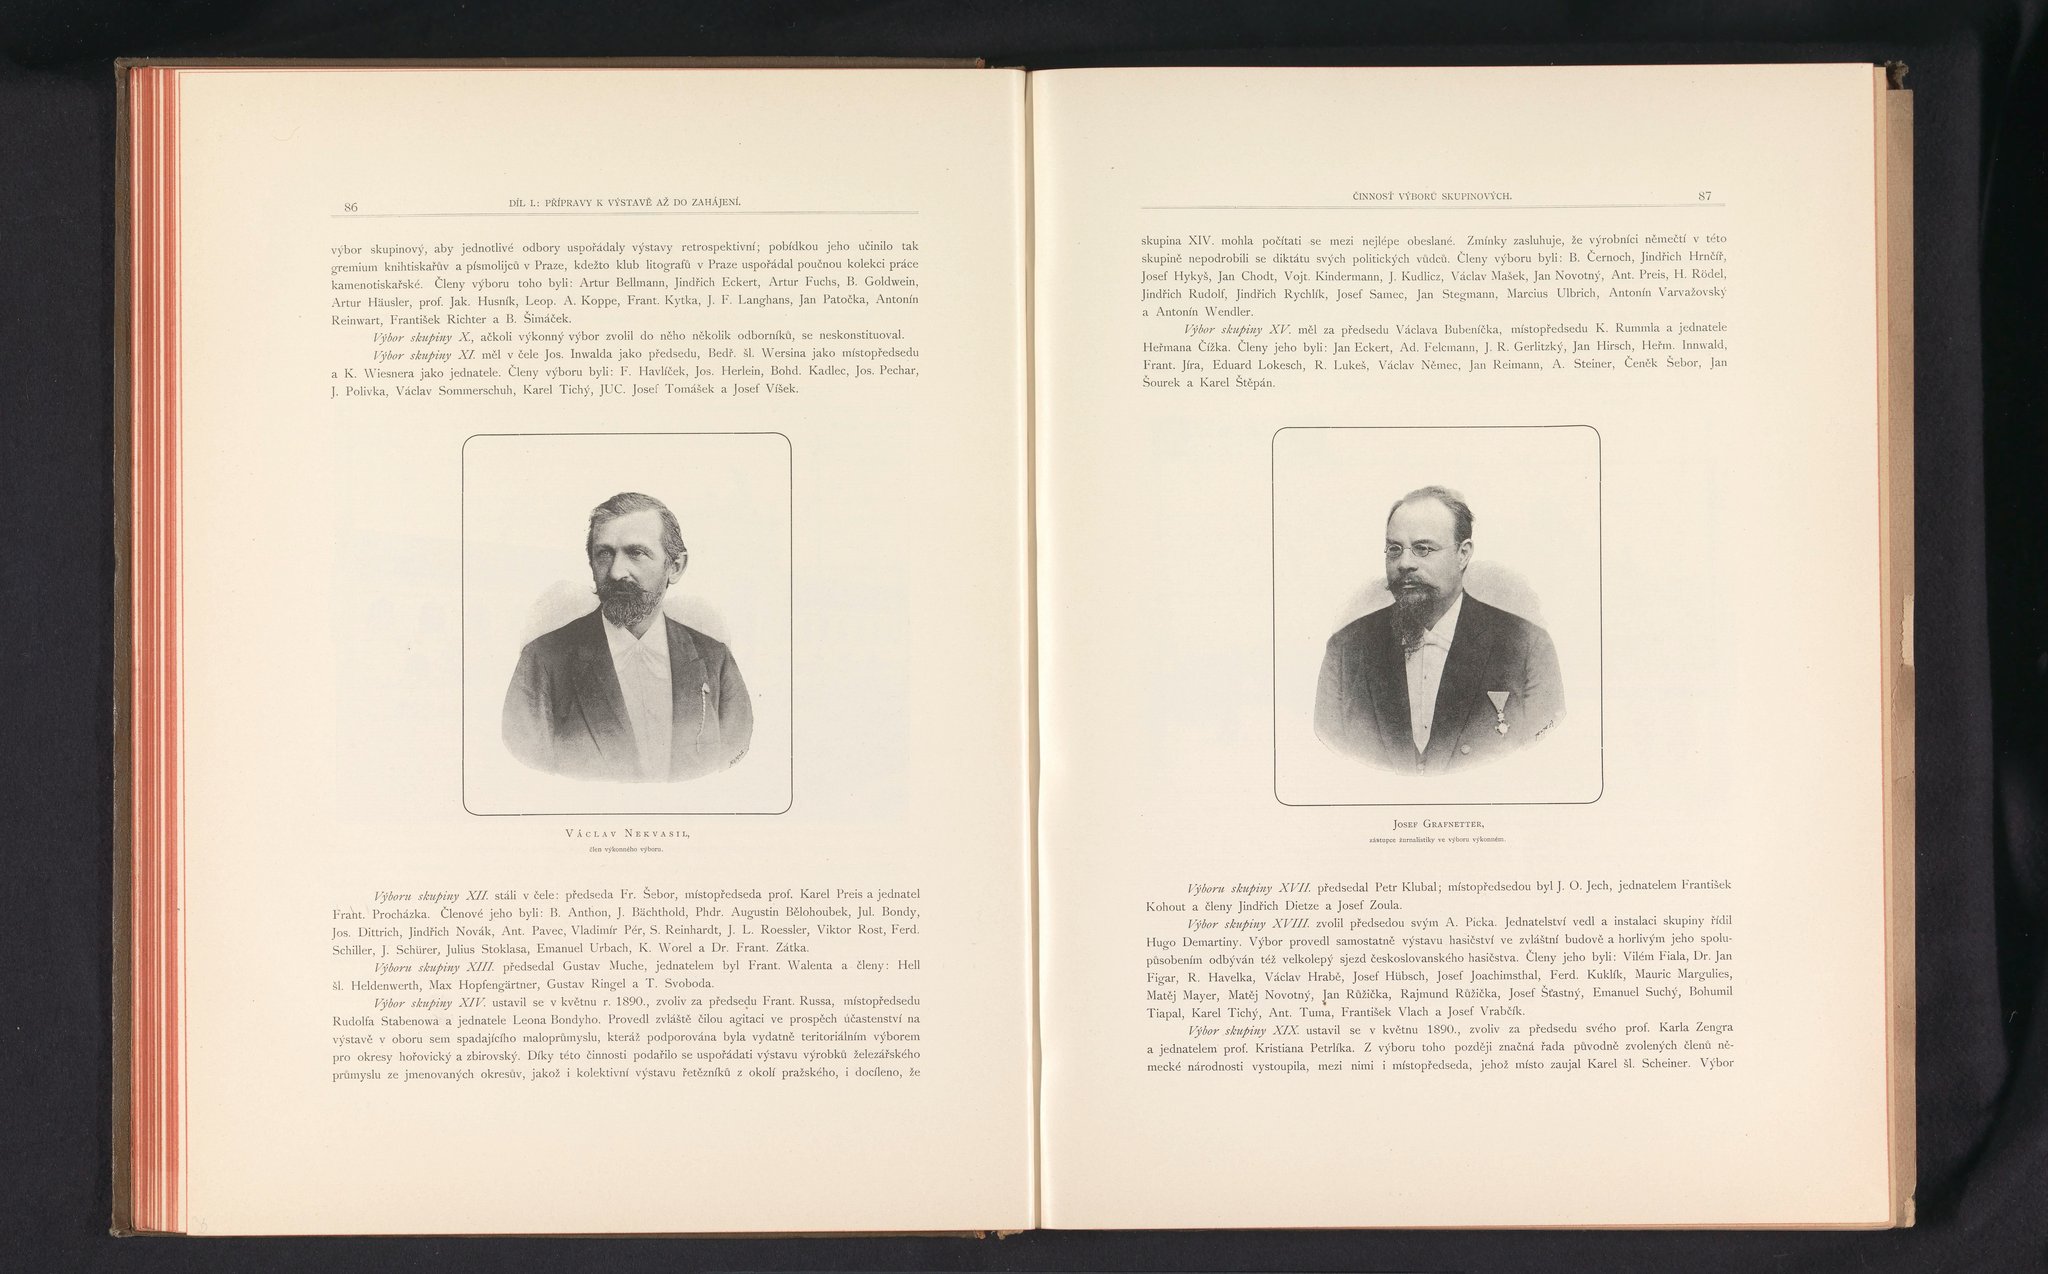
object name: page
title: Portret van Josef Grafnetter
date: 1888-1893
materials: paper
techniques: autotype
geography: prague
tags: adult man